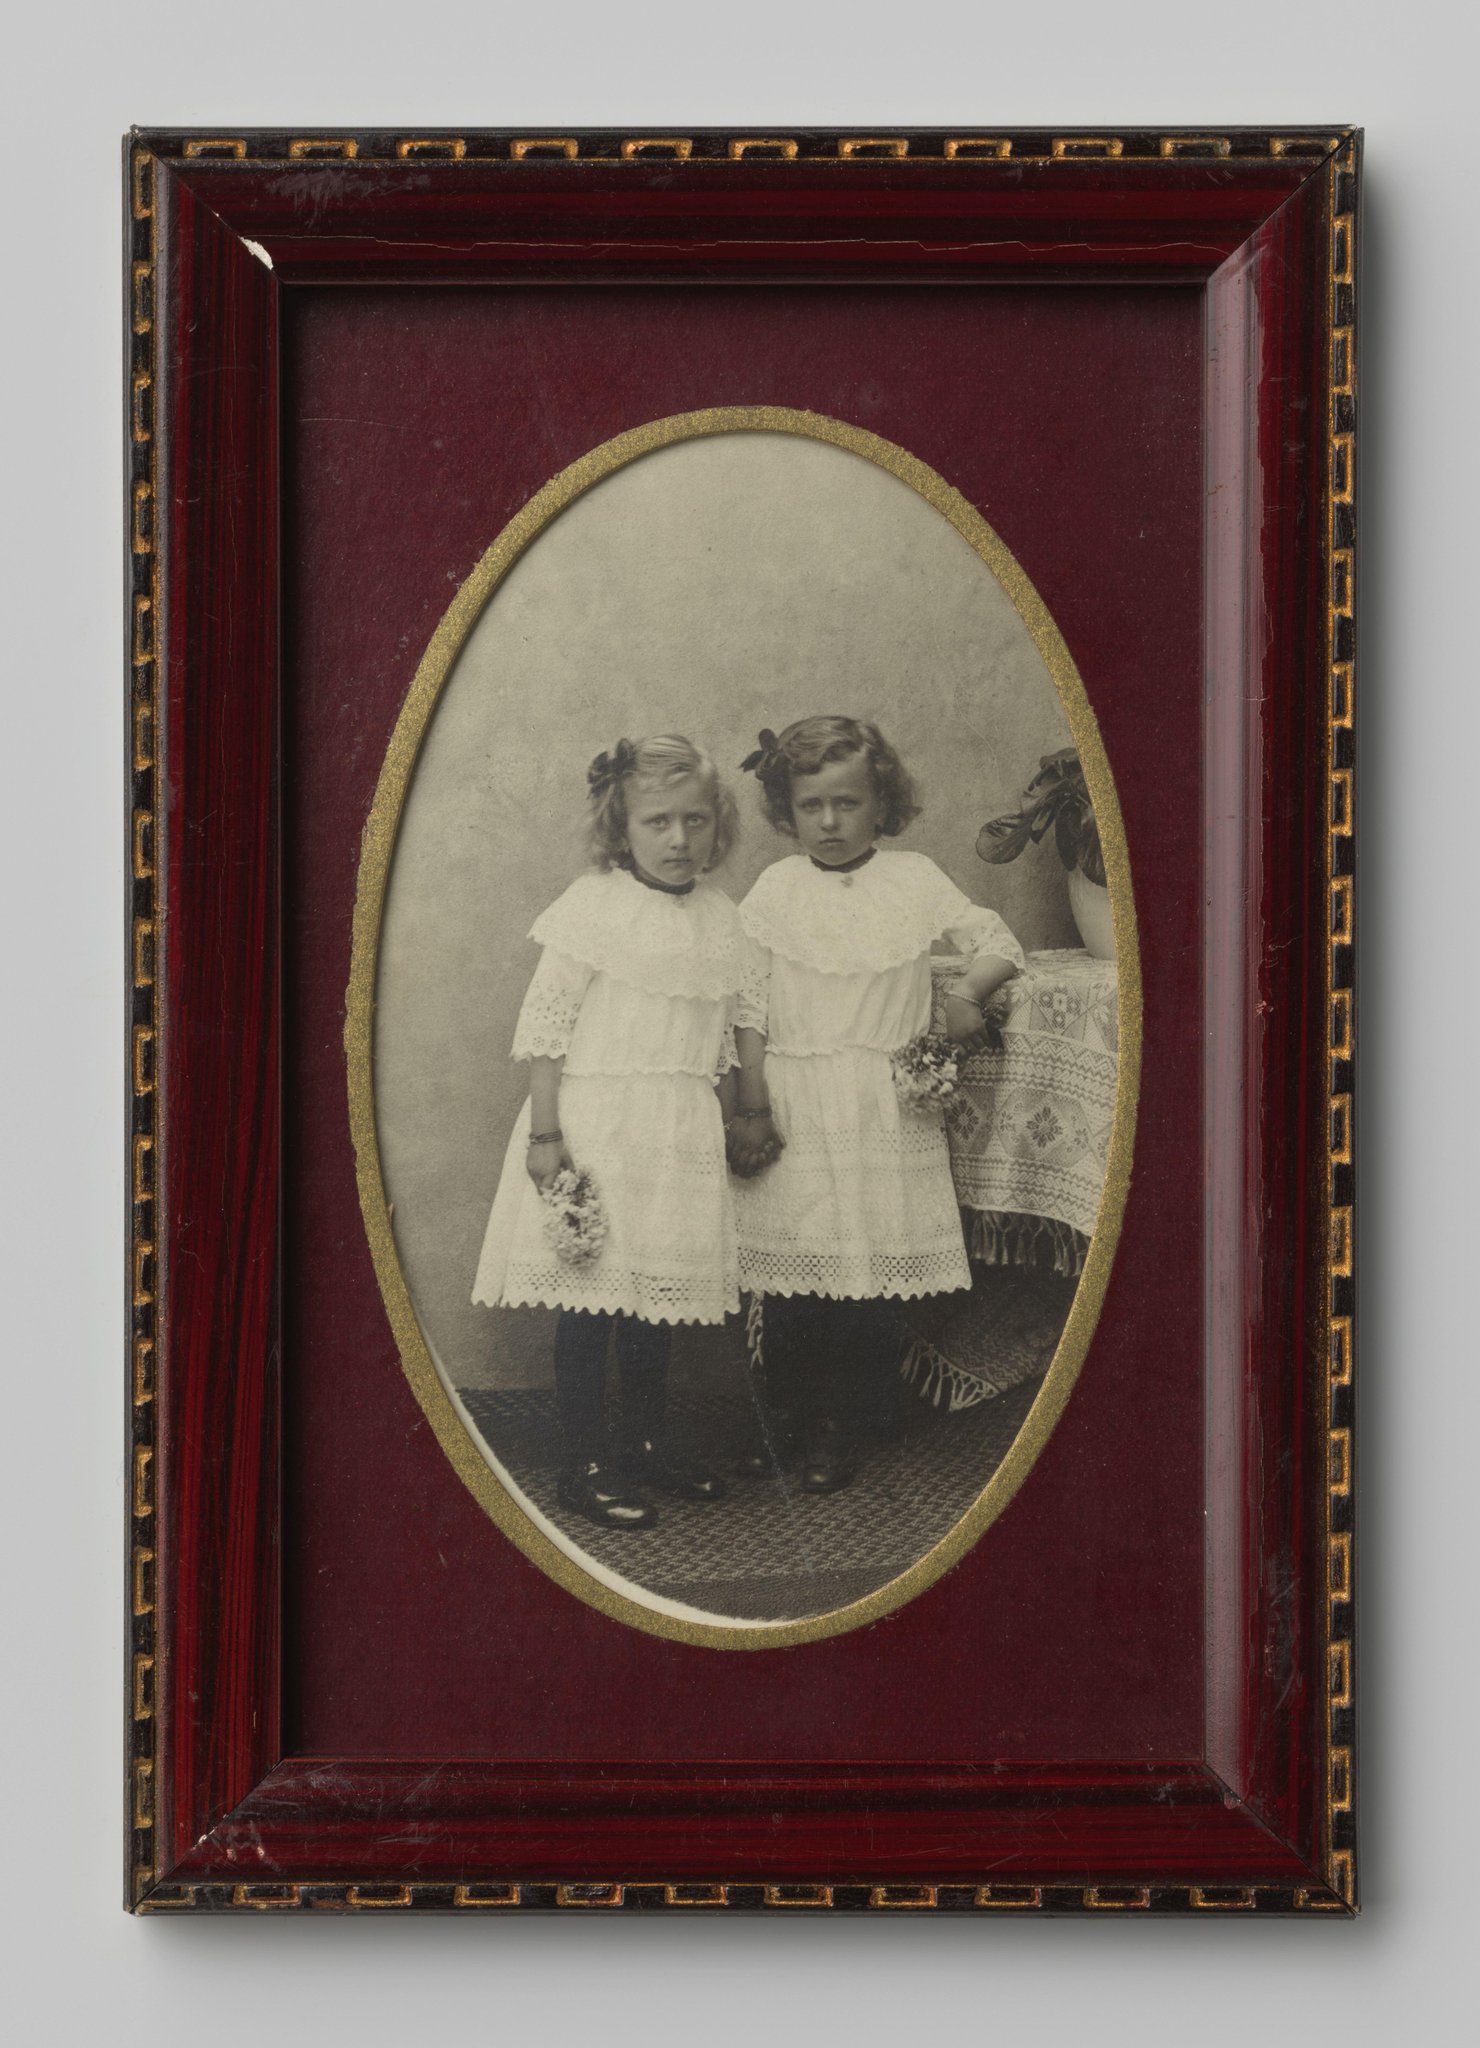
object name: photograph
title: Portret van twee onbekende meisjes hand in hand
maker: Anonymous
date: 1880-1900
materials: paper, cardboard, glass, wood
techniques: gelatin silver print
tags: gripping someone by the hand or the wrist; clasped hands - aa - both arms or hands, girl (child between toddler and youth), anonymous historical persons portrayed in a double portrait